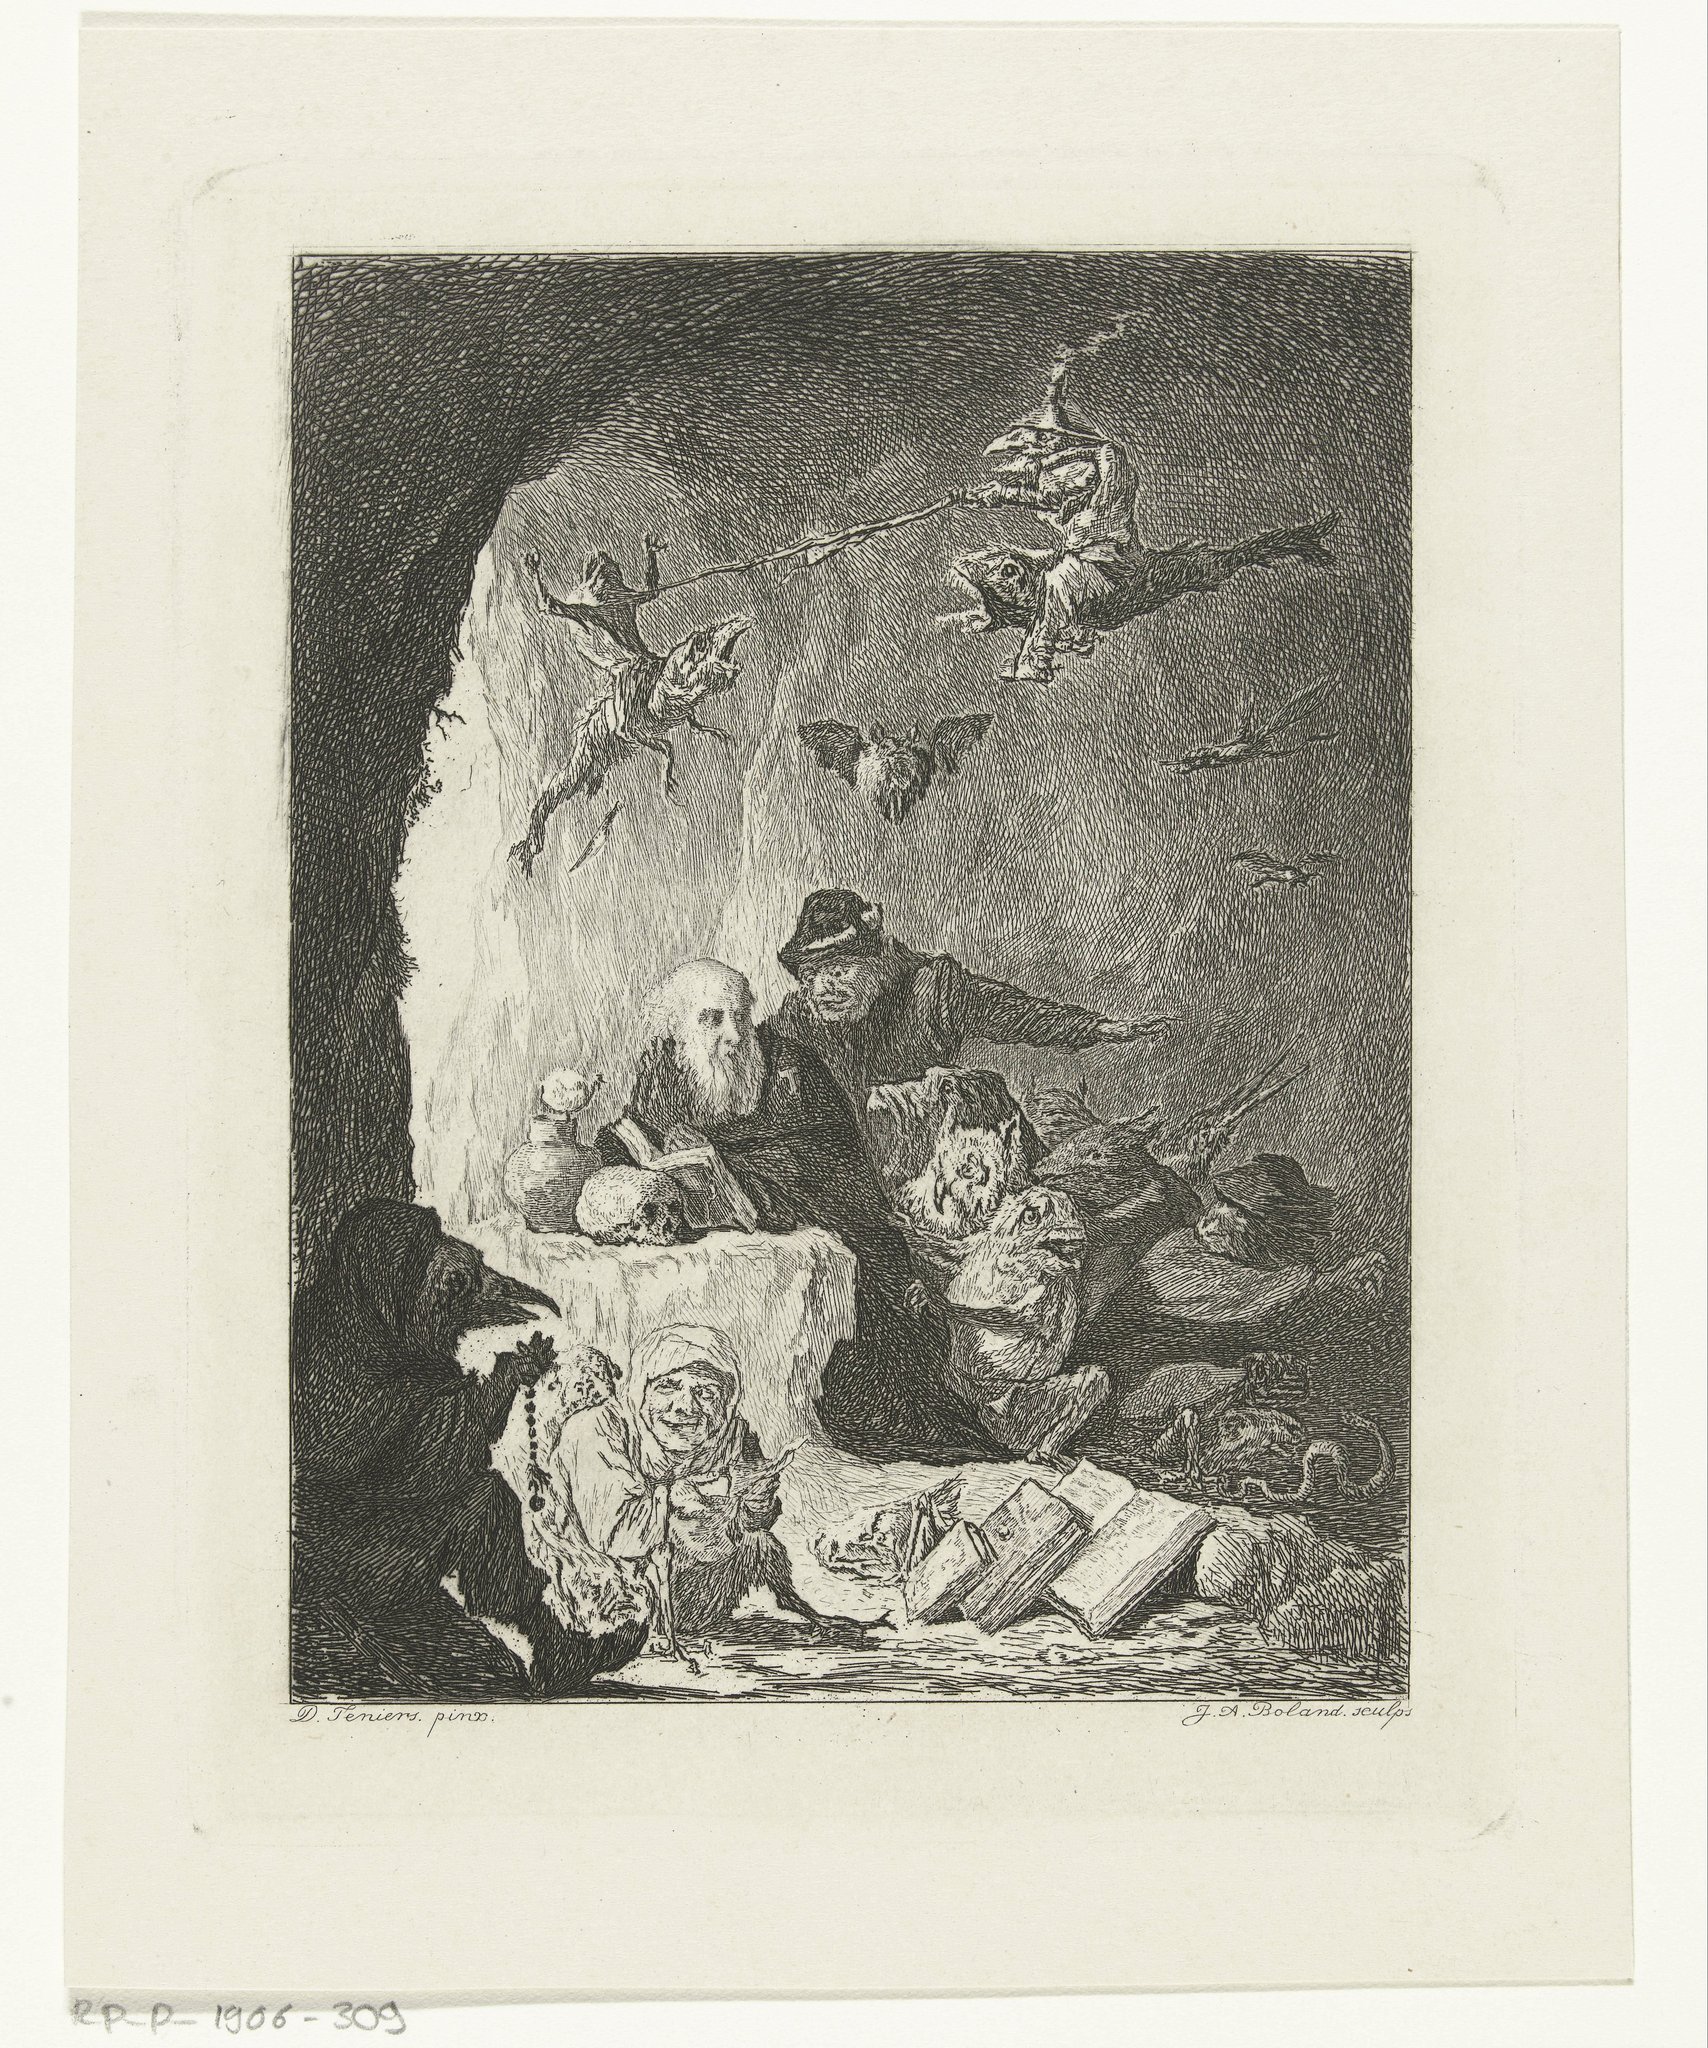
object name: print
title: De verzoeking van de heilige Antonius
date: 1860-1900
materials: paper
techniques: etching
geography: amsterdam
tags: st. antony abbot tormented by devils, attacking him on the ground or carrying him aloft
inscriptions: collector's mark: Lugt 2228